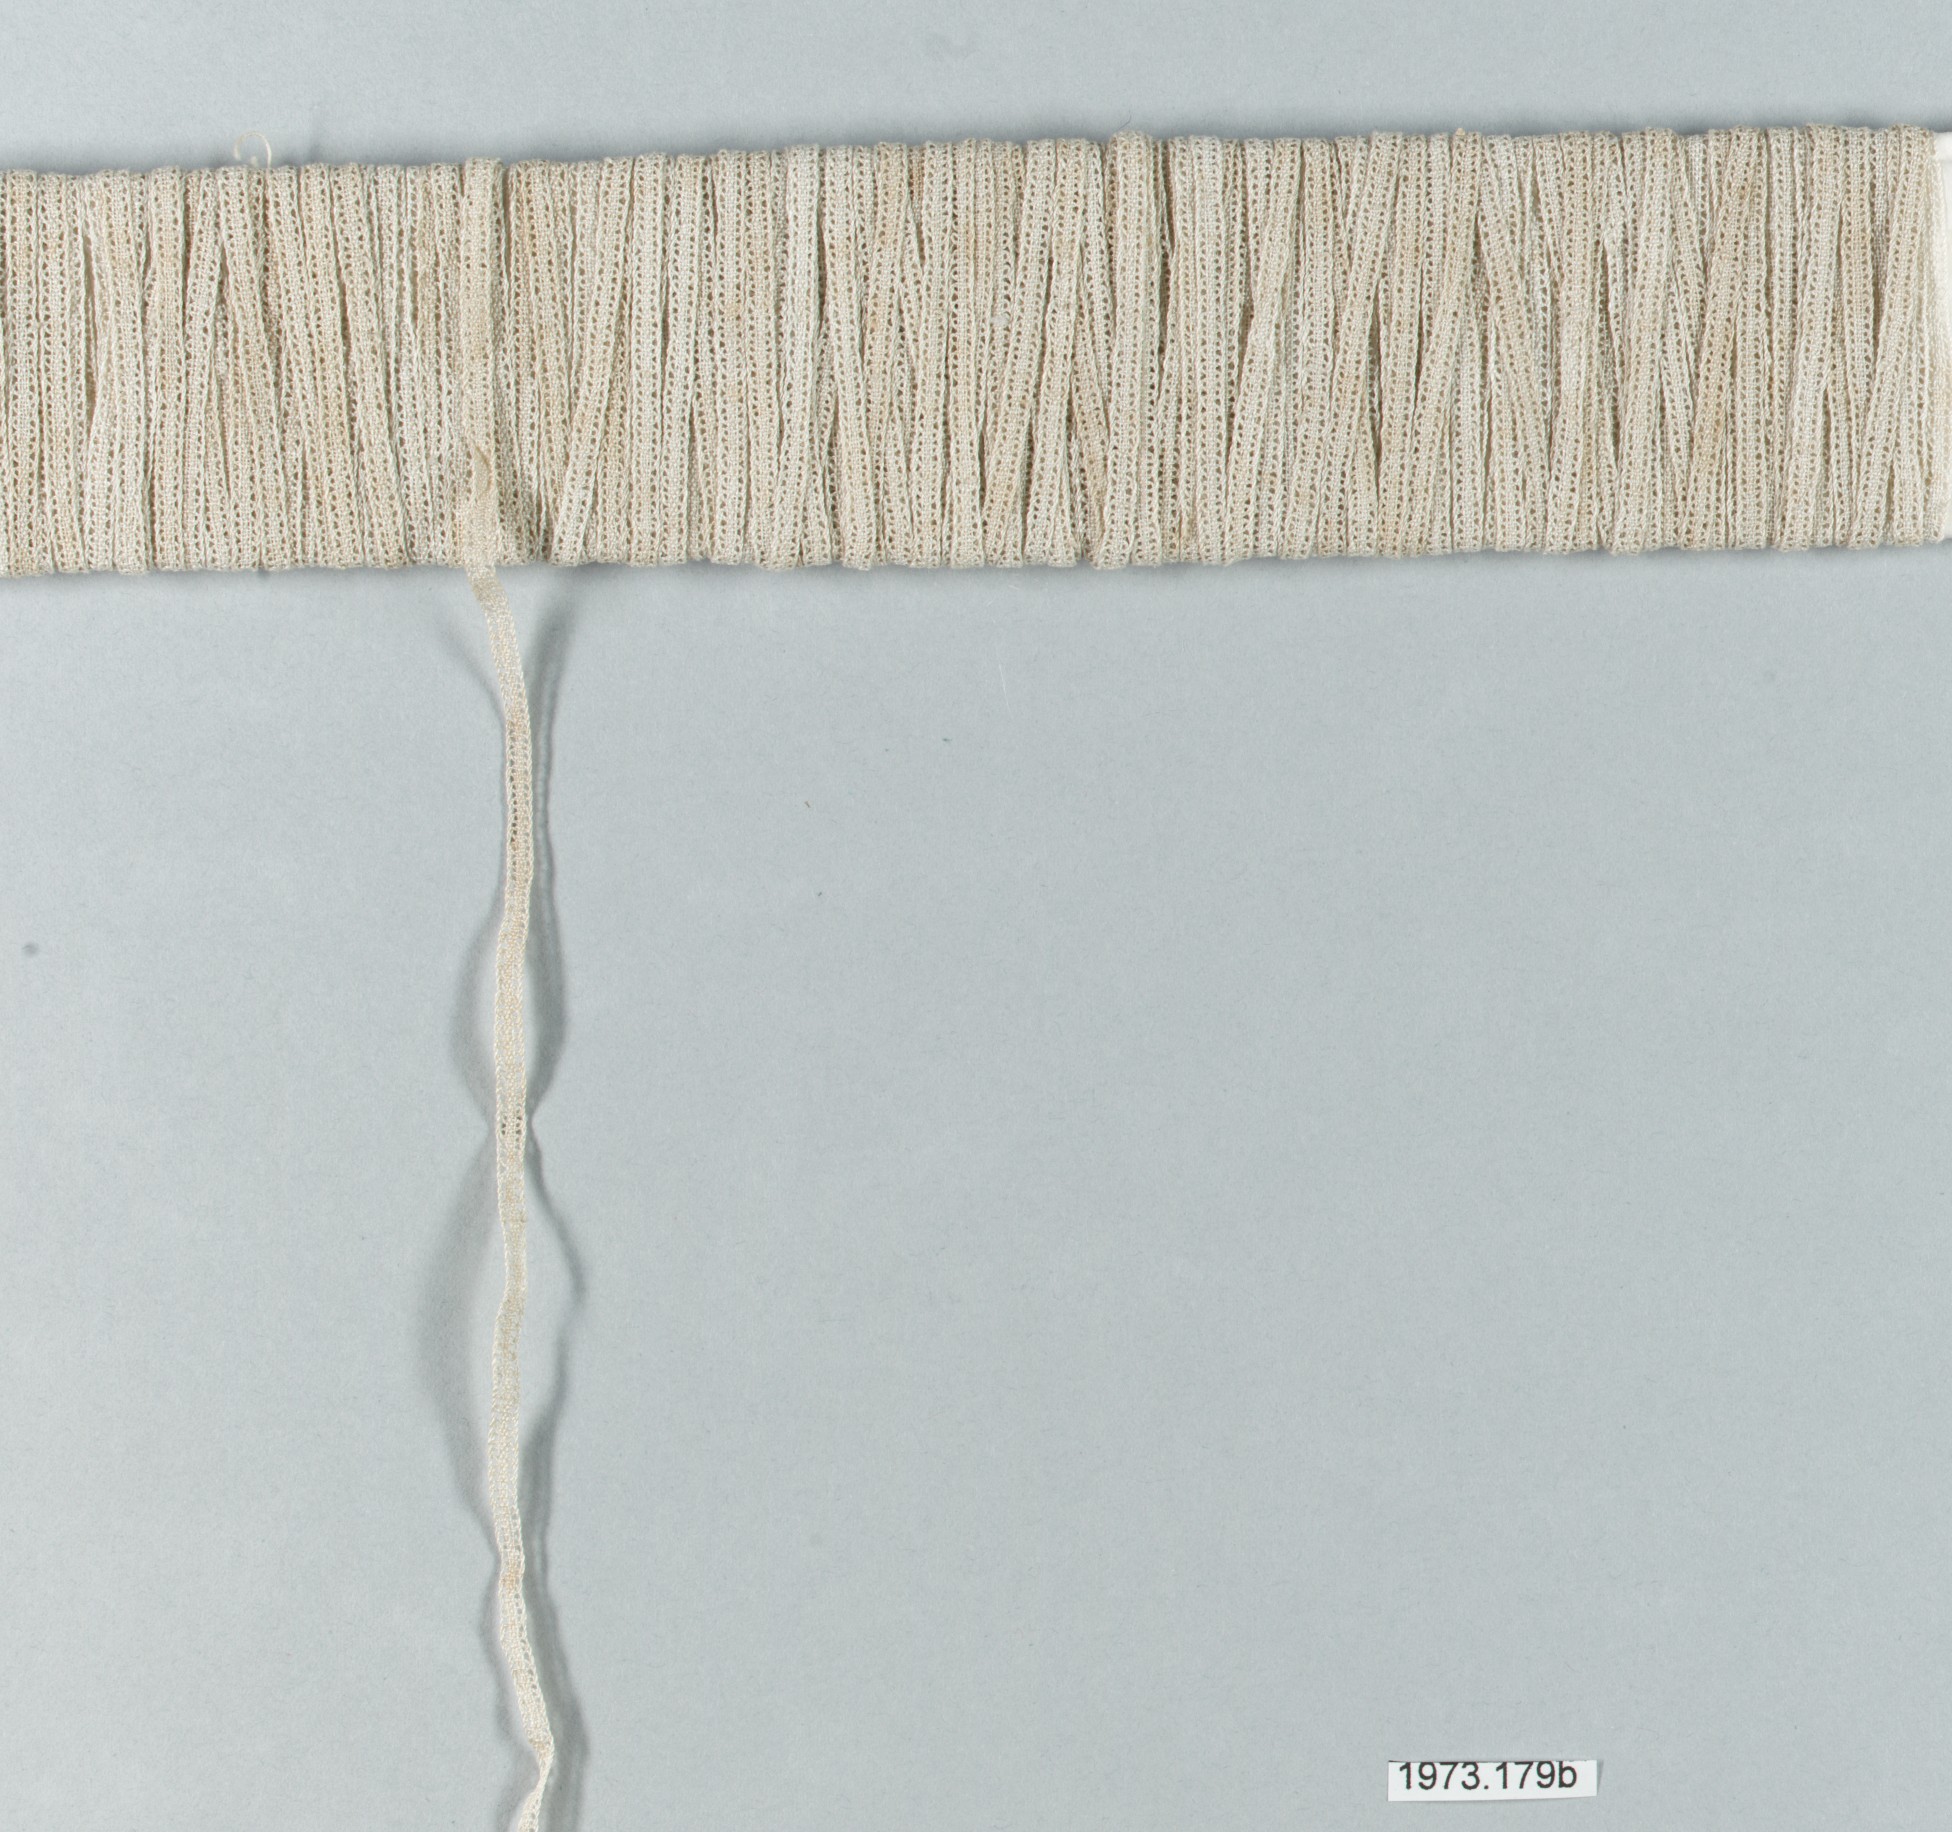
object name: length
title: Two lengths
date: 1801-1900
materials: linen